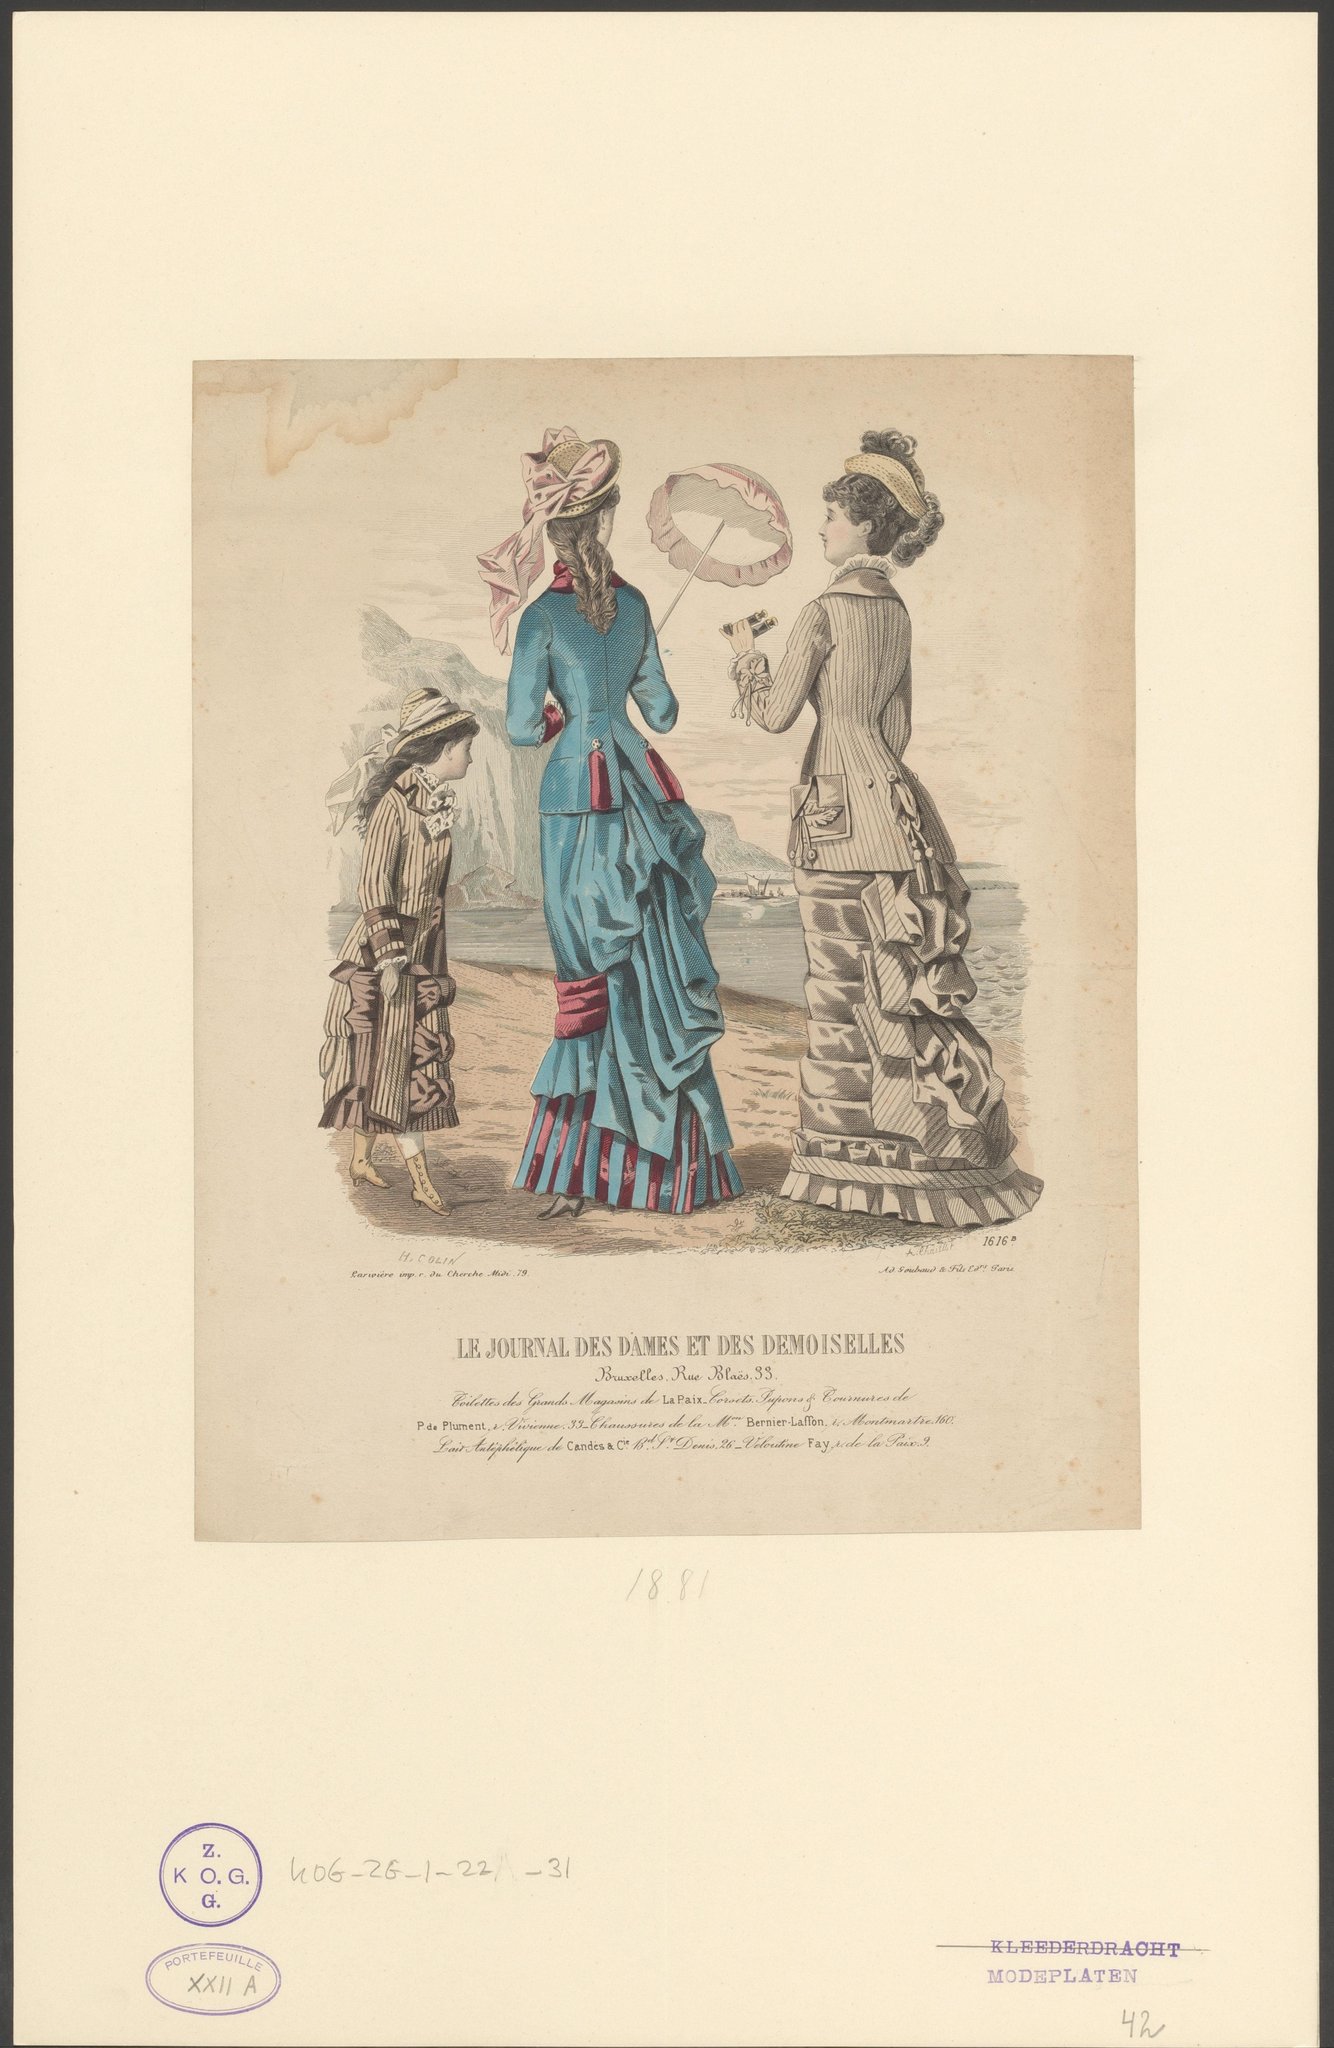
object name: print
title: Twee vrouwen en een meisje aan het strand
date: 1881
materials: paper, watercolor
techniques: etching, hand coloring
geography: france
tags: fashion plates, clothes, costume (+ women's clothes), dress, gown (+ women's clothes), in or beside the water (on the beach)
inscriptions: collector's mark: Lugt 1641, collector's mark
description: Twee vrouwen en een meisje aan het strand. Prent uit het modetijdschrift 'Le Journal des Dames et des Demoiselles'. Onderwerpsrubrieken binnen de Atlas Zeden en Gewoonten: De Kleeding, Modeplaten.